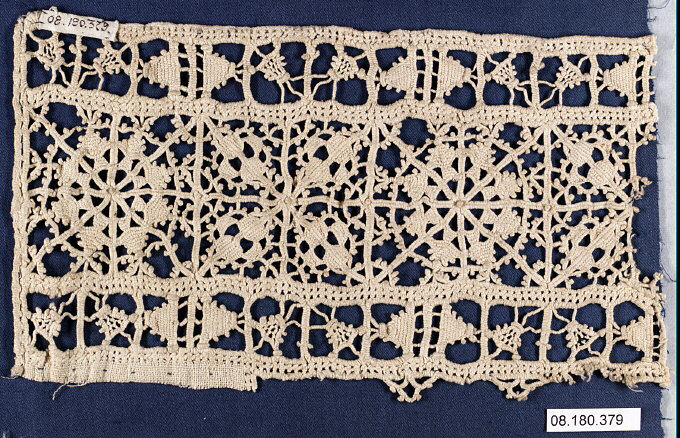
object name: fragment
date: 1701-1800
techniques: lace